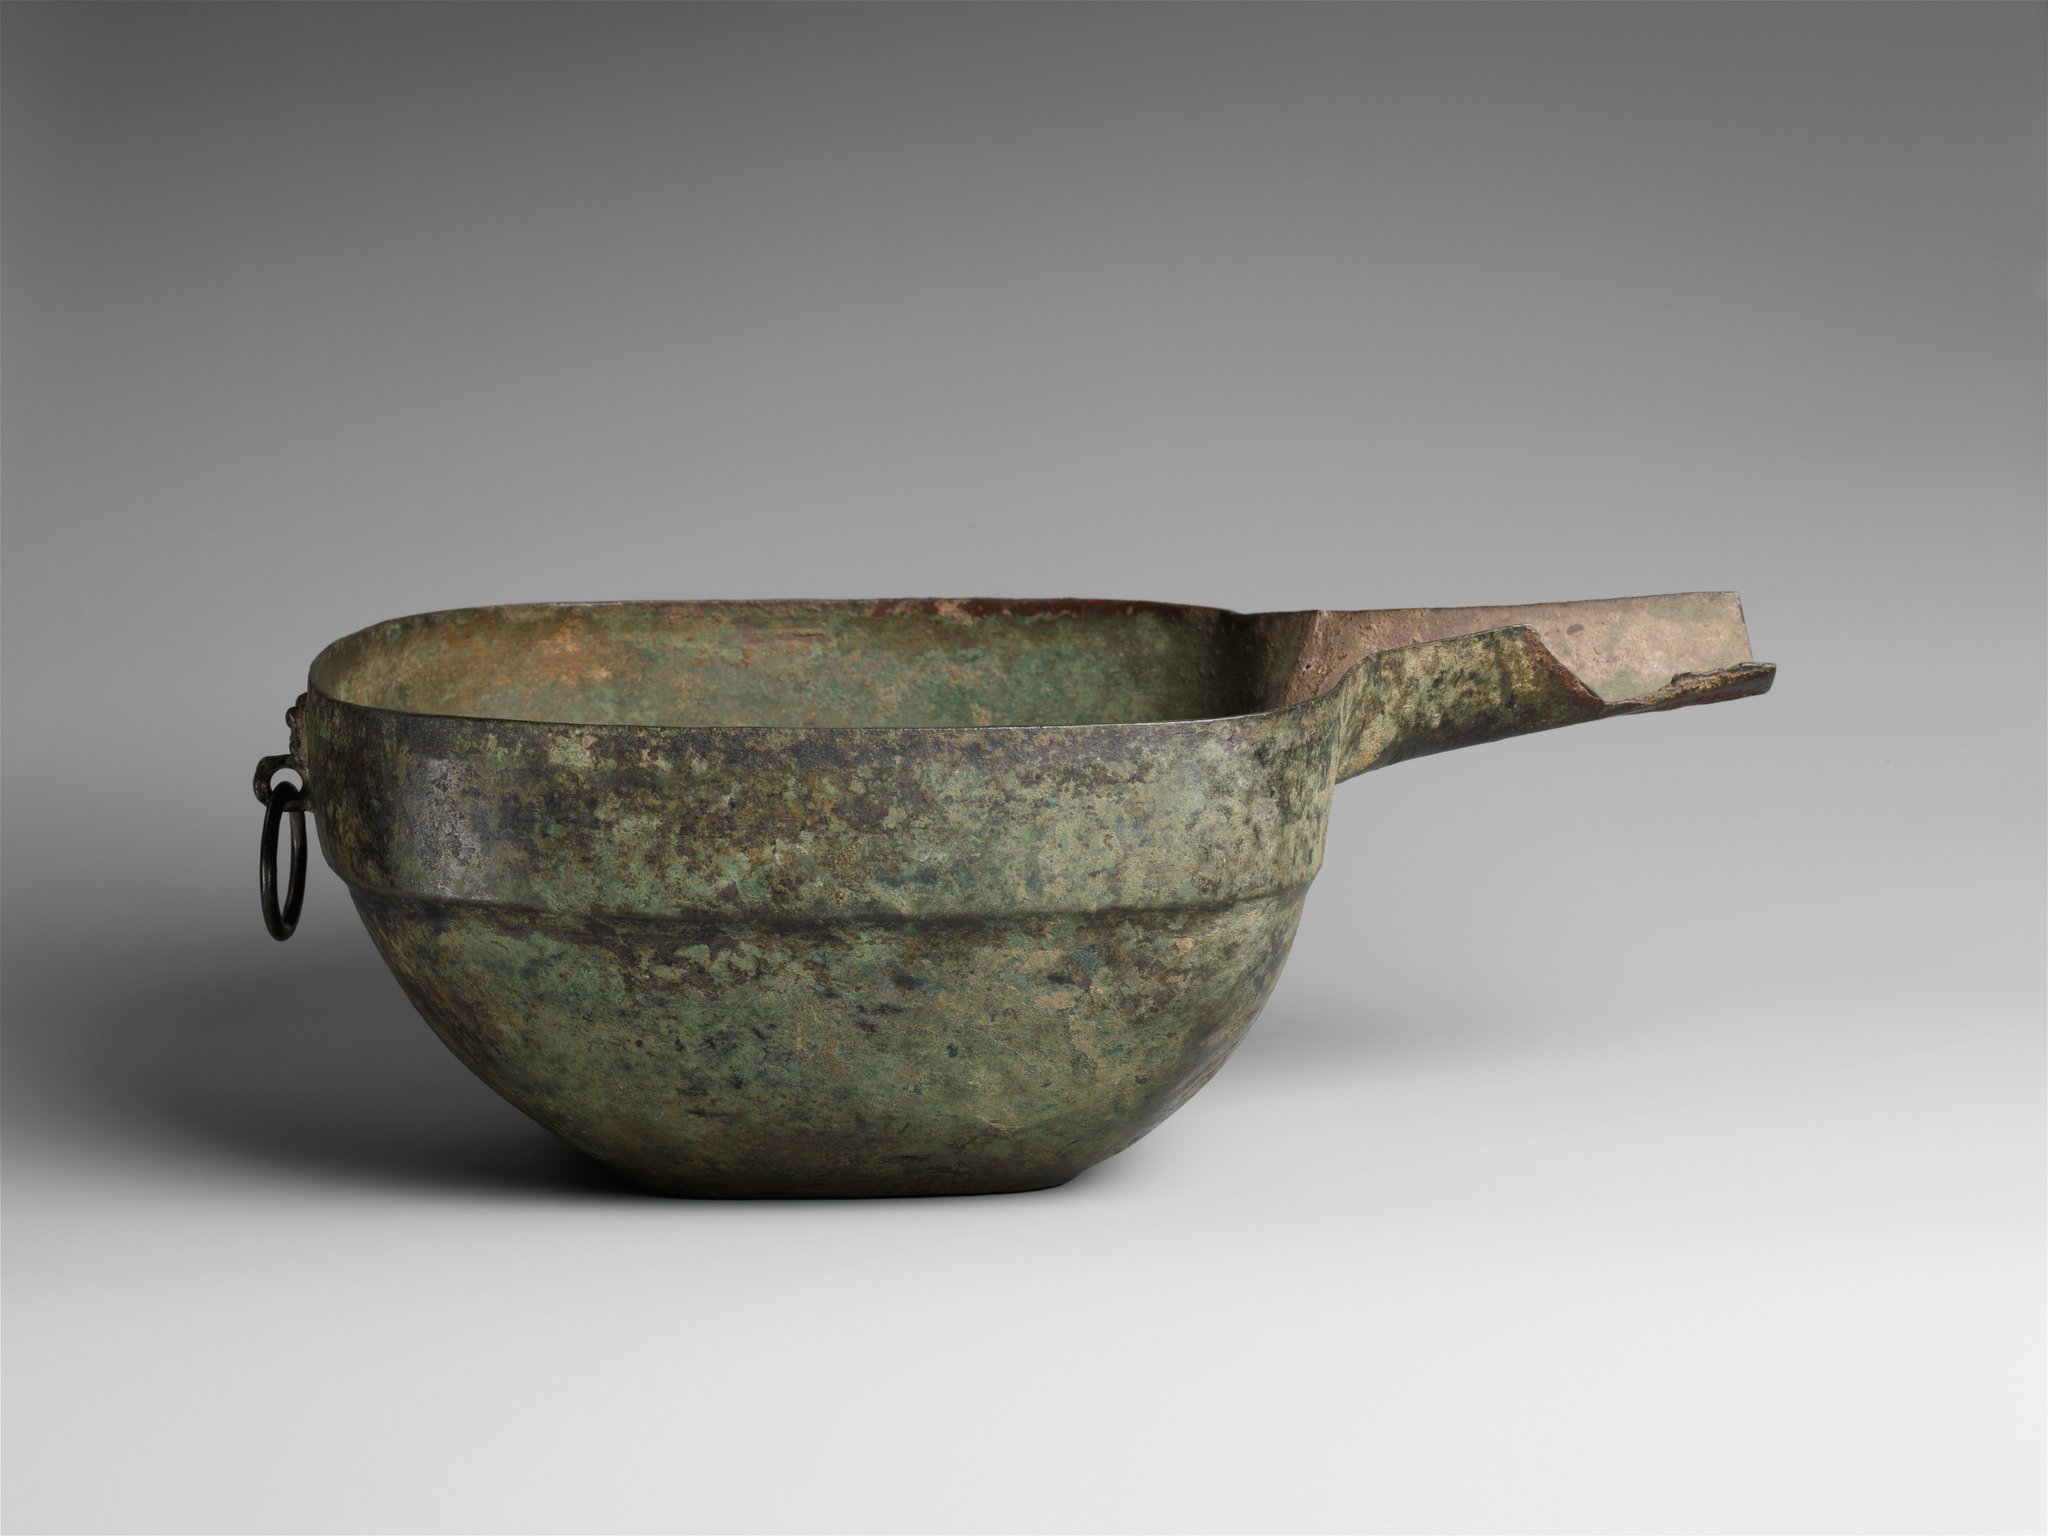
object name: water ewer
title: Water ewer (Yi)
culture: chinese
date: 206 BCE-220 CE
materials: bronze